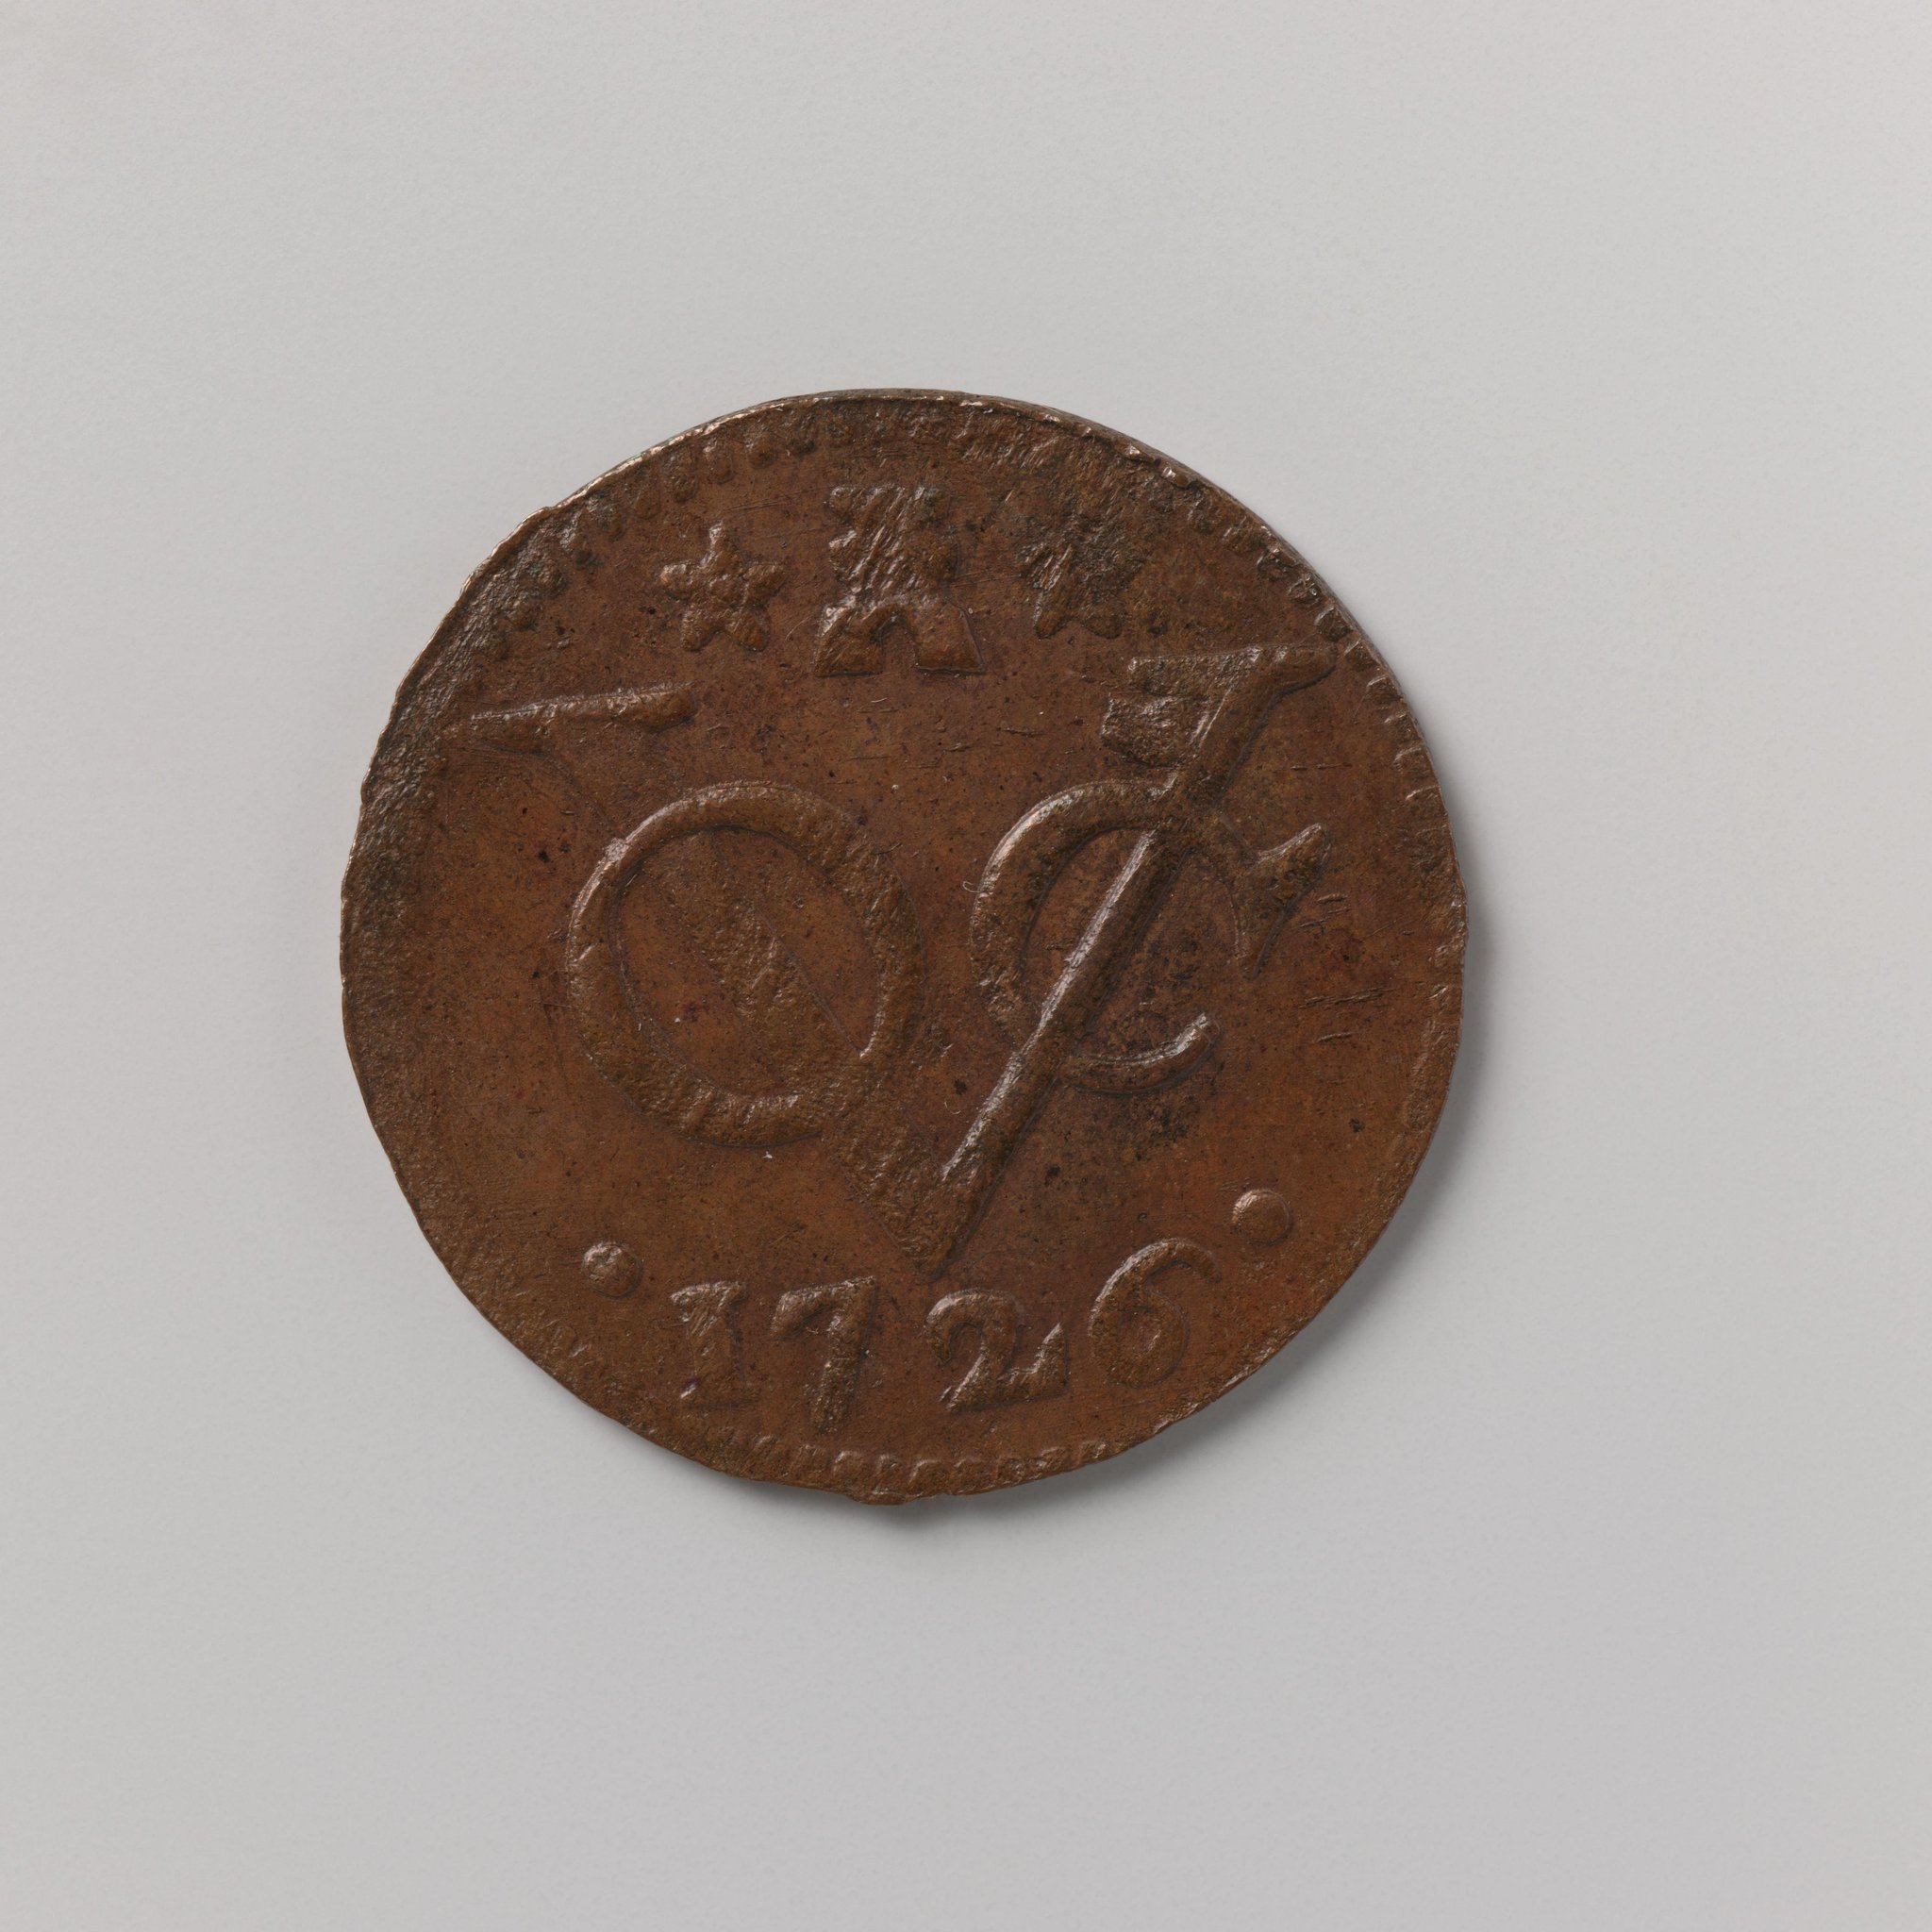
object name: coin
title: Duit van de VOC uit Zeeland, 1726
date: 1726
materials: copper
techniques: striking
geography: middelburg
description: Koperen munt. Voorzijde: gekroond ingebogen wapenschild van Zeeland en omschrift. Keerzijde: monogram van de VOC, waarboven muntteken en waaronder jaartal. Gladde rand.